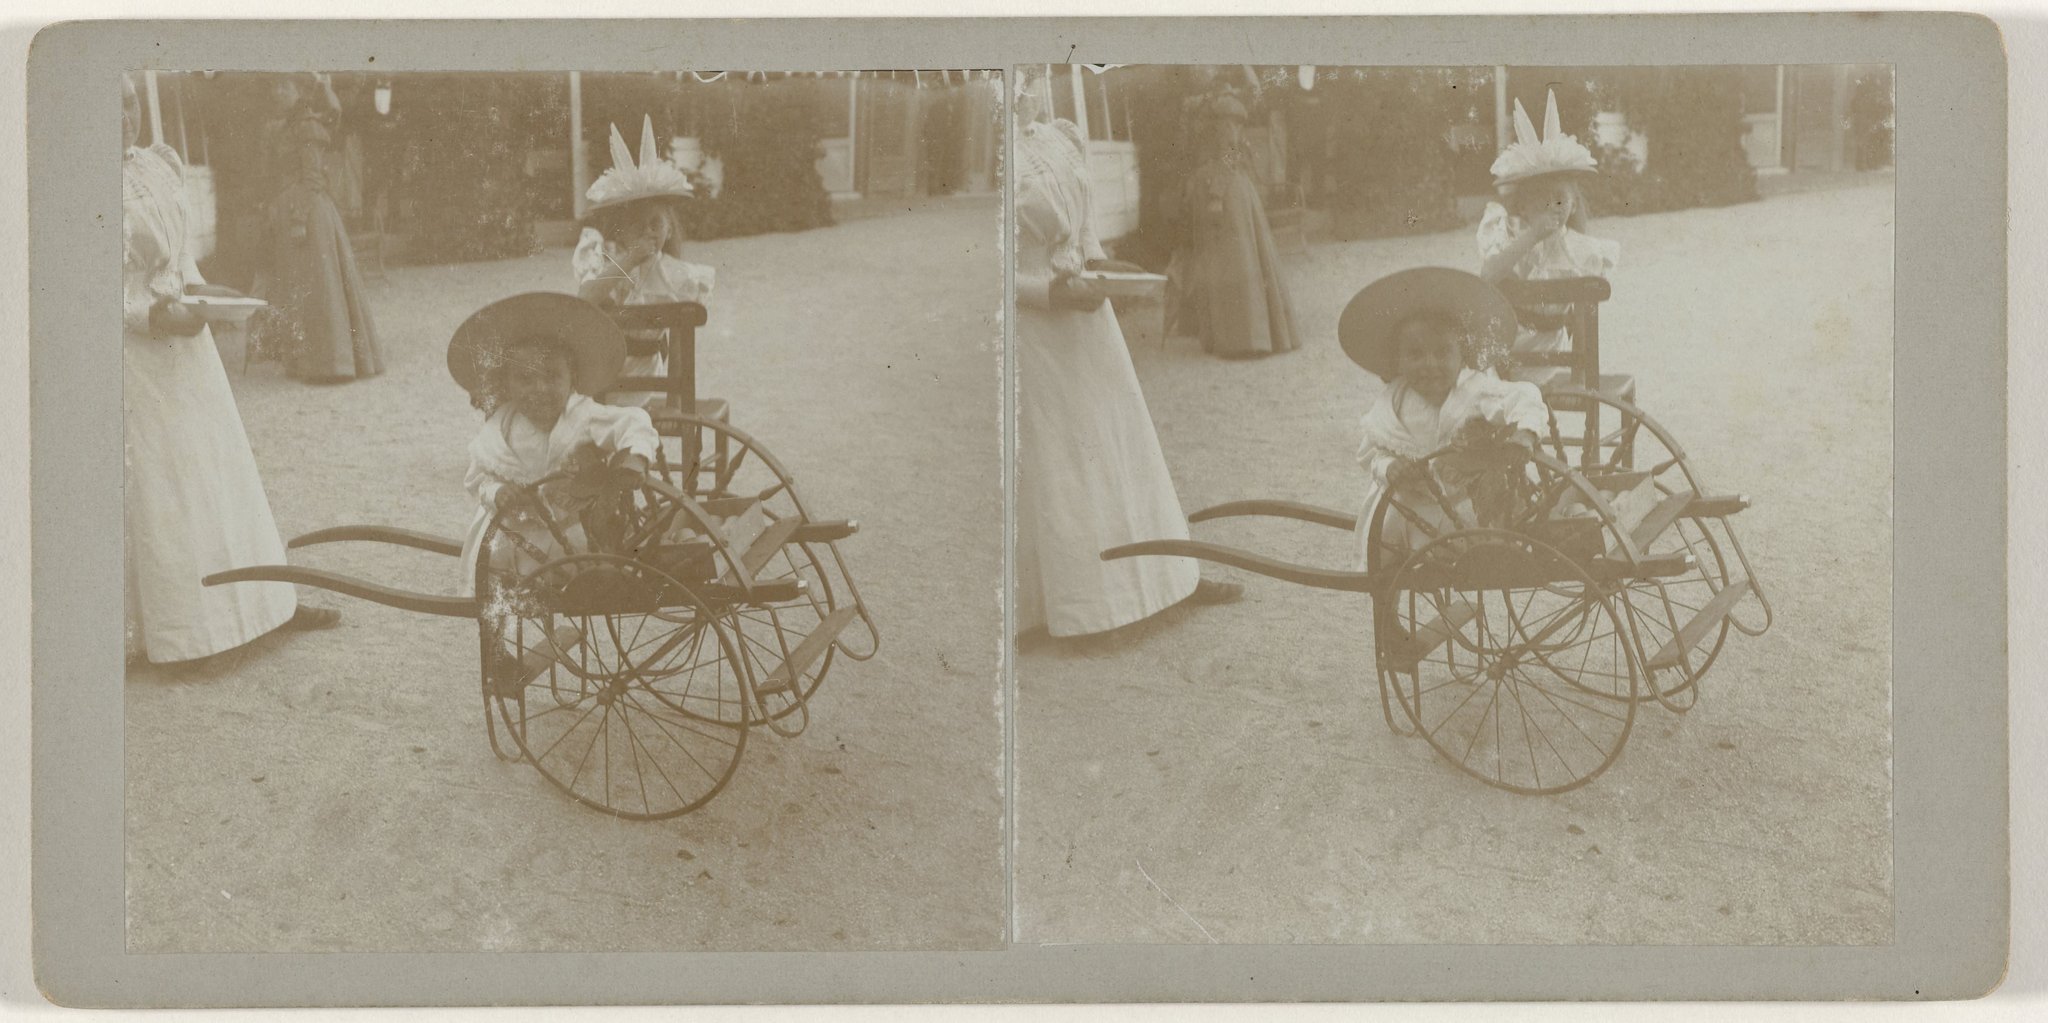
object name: stereograph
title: Klein kind in een handkar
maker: geldolph adriaan kessler (dolph)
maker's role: fotograaf, industrieel, voetballer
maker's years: 1884-1945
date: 1899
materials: paper, photographic support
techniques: collodion silver print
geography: netherlands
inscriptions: caption: ‘aug. 1899 Domburg’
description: Op de achtergrond zit een kleinmeisje met een witte hoed met strikken op een stoel.